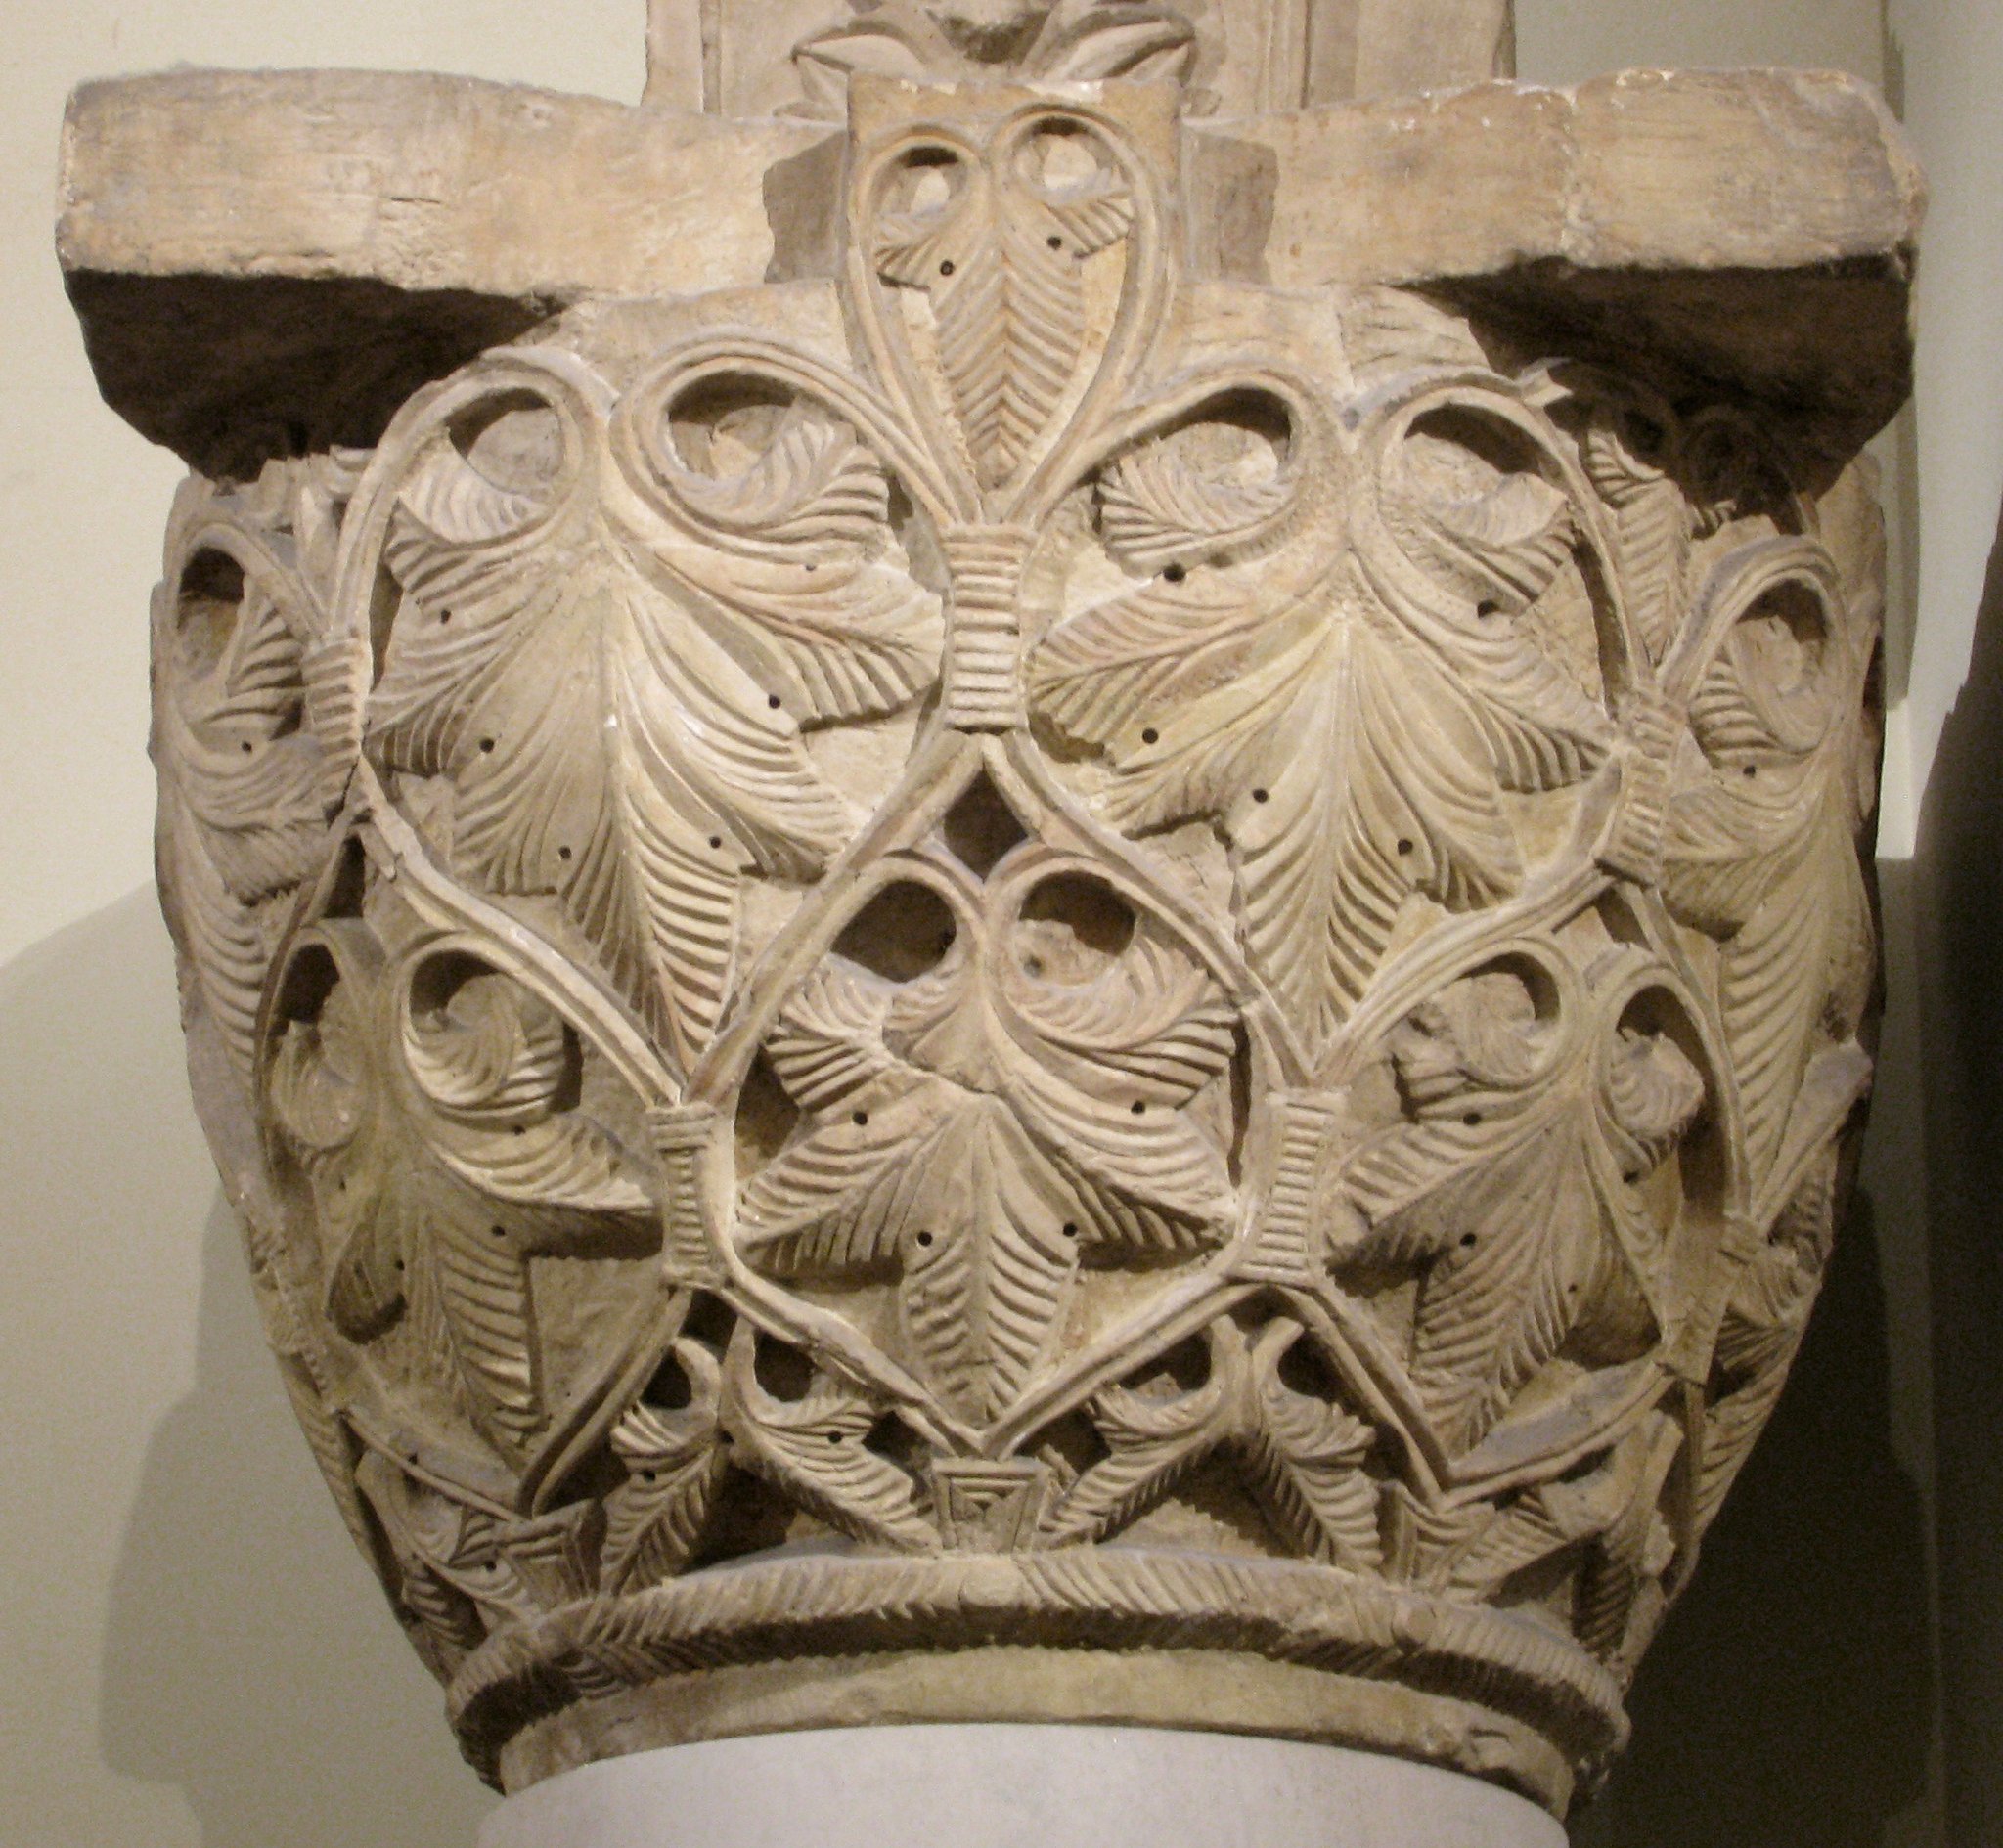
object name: capital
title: Capital with a Pattern of Leaves and Vines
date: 501-700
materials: limestone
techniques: carving, relief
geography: egypt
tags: leaves,vines